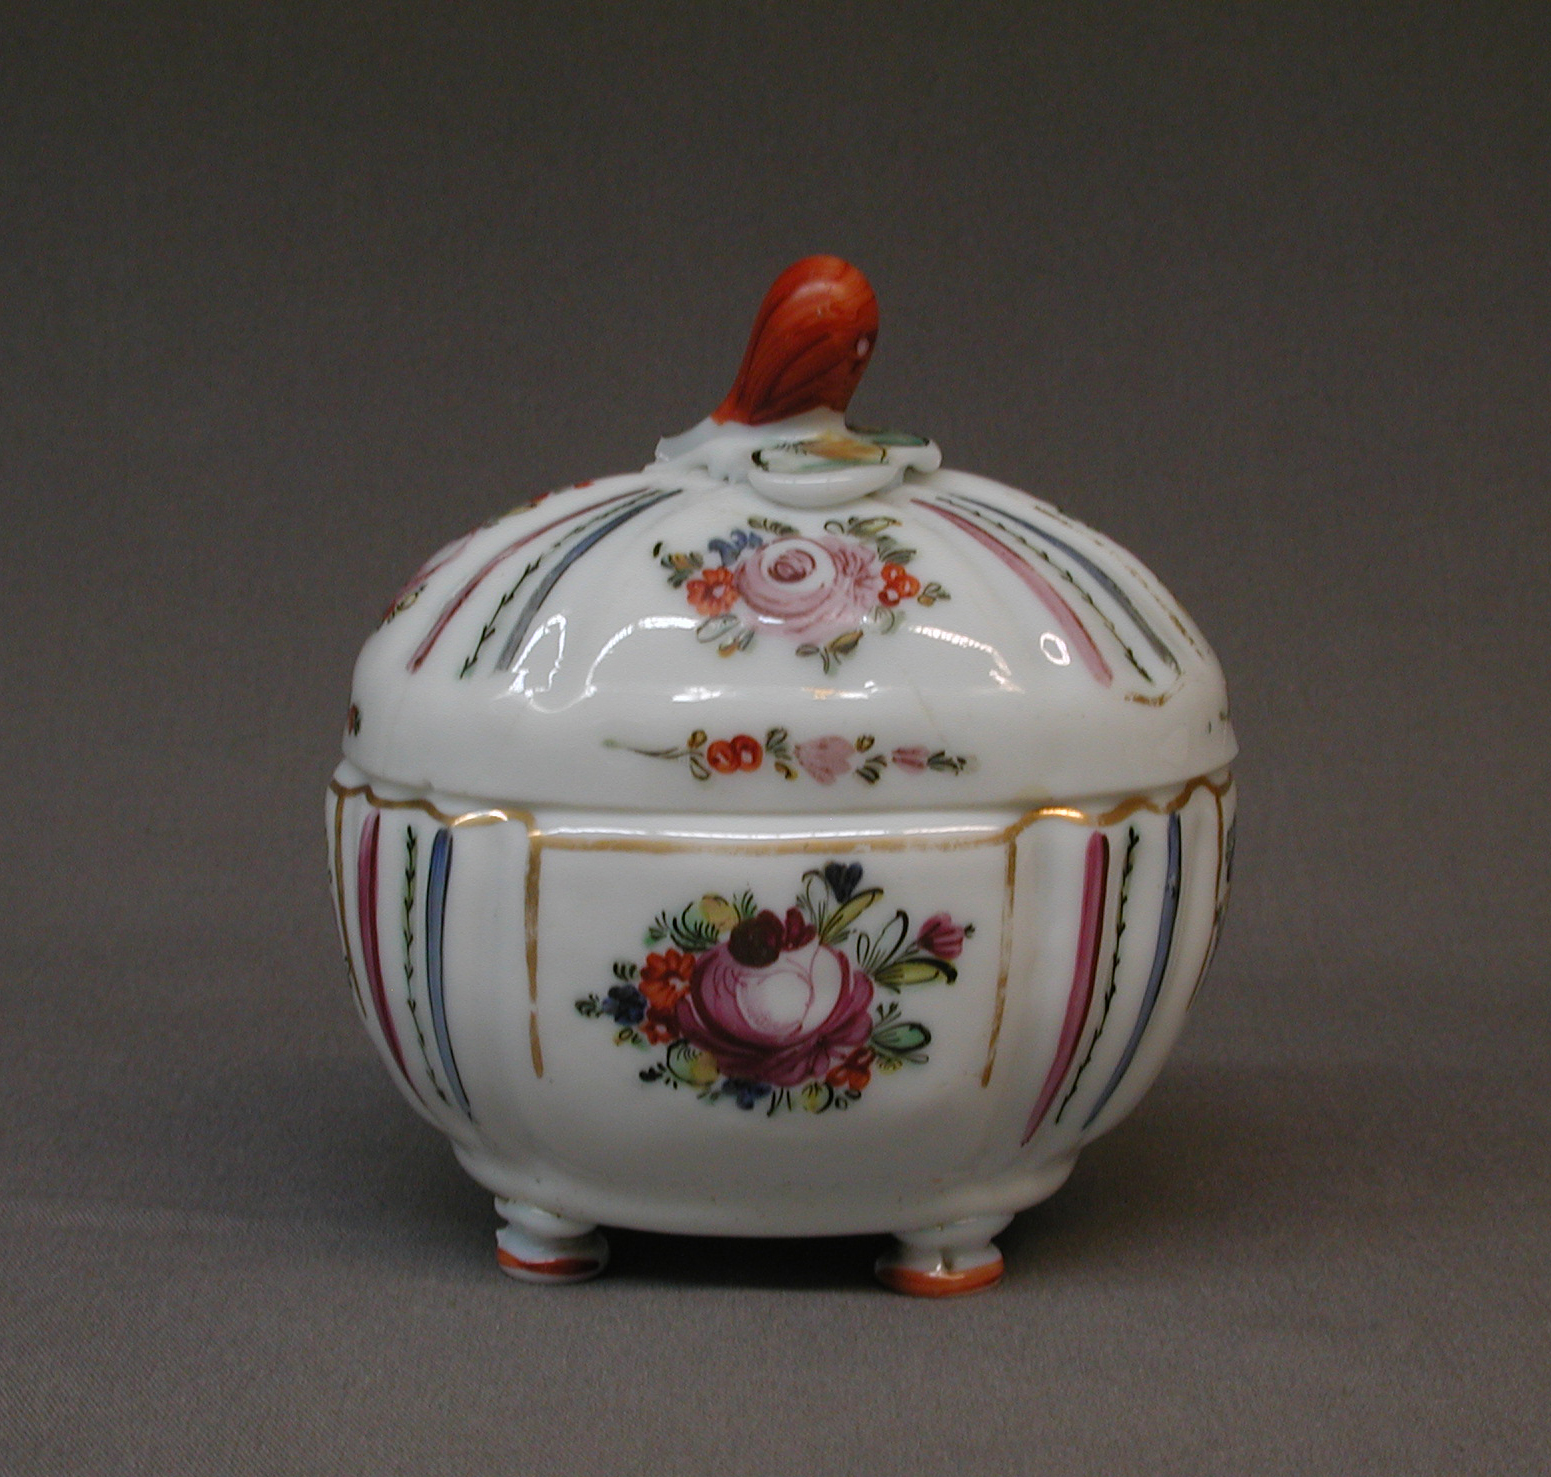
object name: bowl with cover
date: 1701-1800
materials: glass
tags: flowers